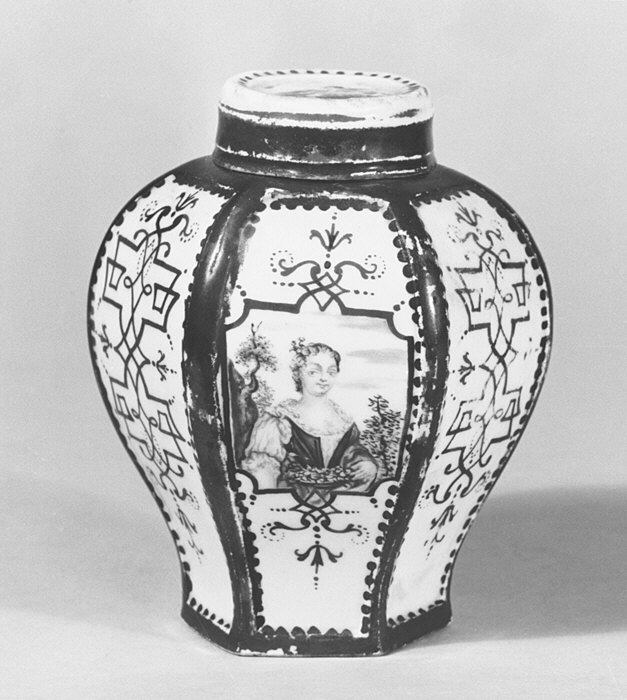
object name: tea caddy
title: Tea caddy (part of a service)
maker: meissen manufactory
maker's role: manufactory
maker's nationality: german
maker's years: 1710-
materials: hard paste porcelain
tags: women